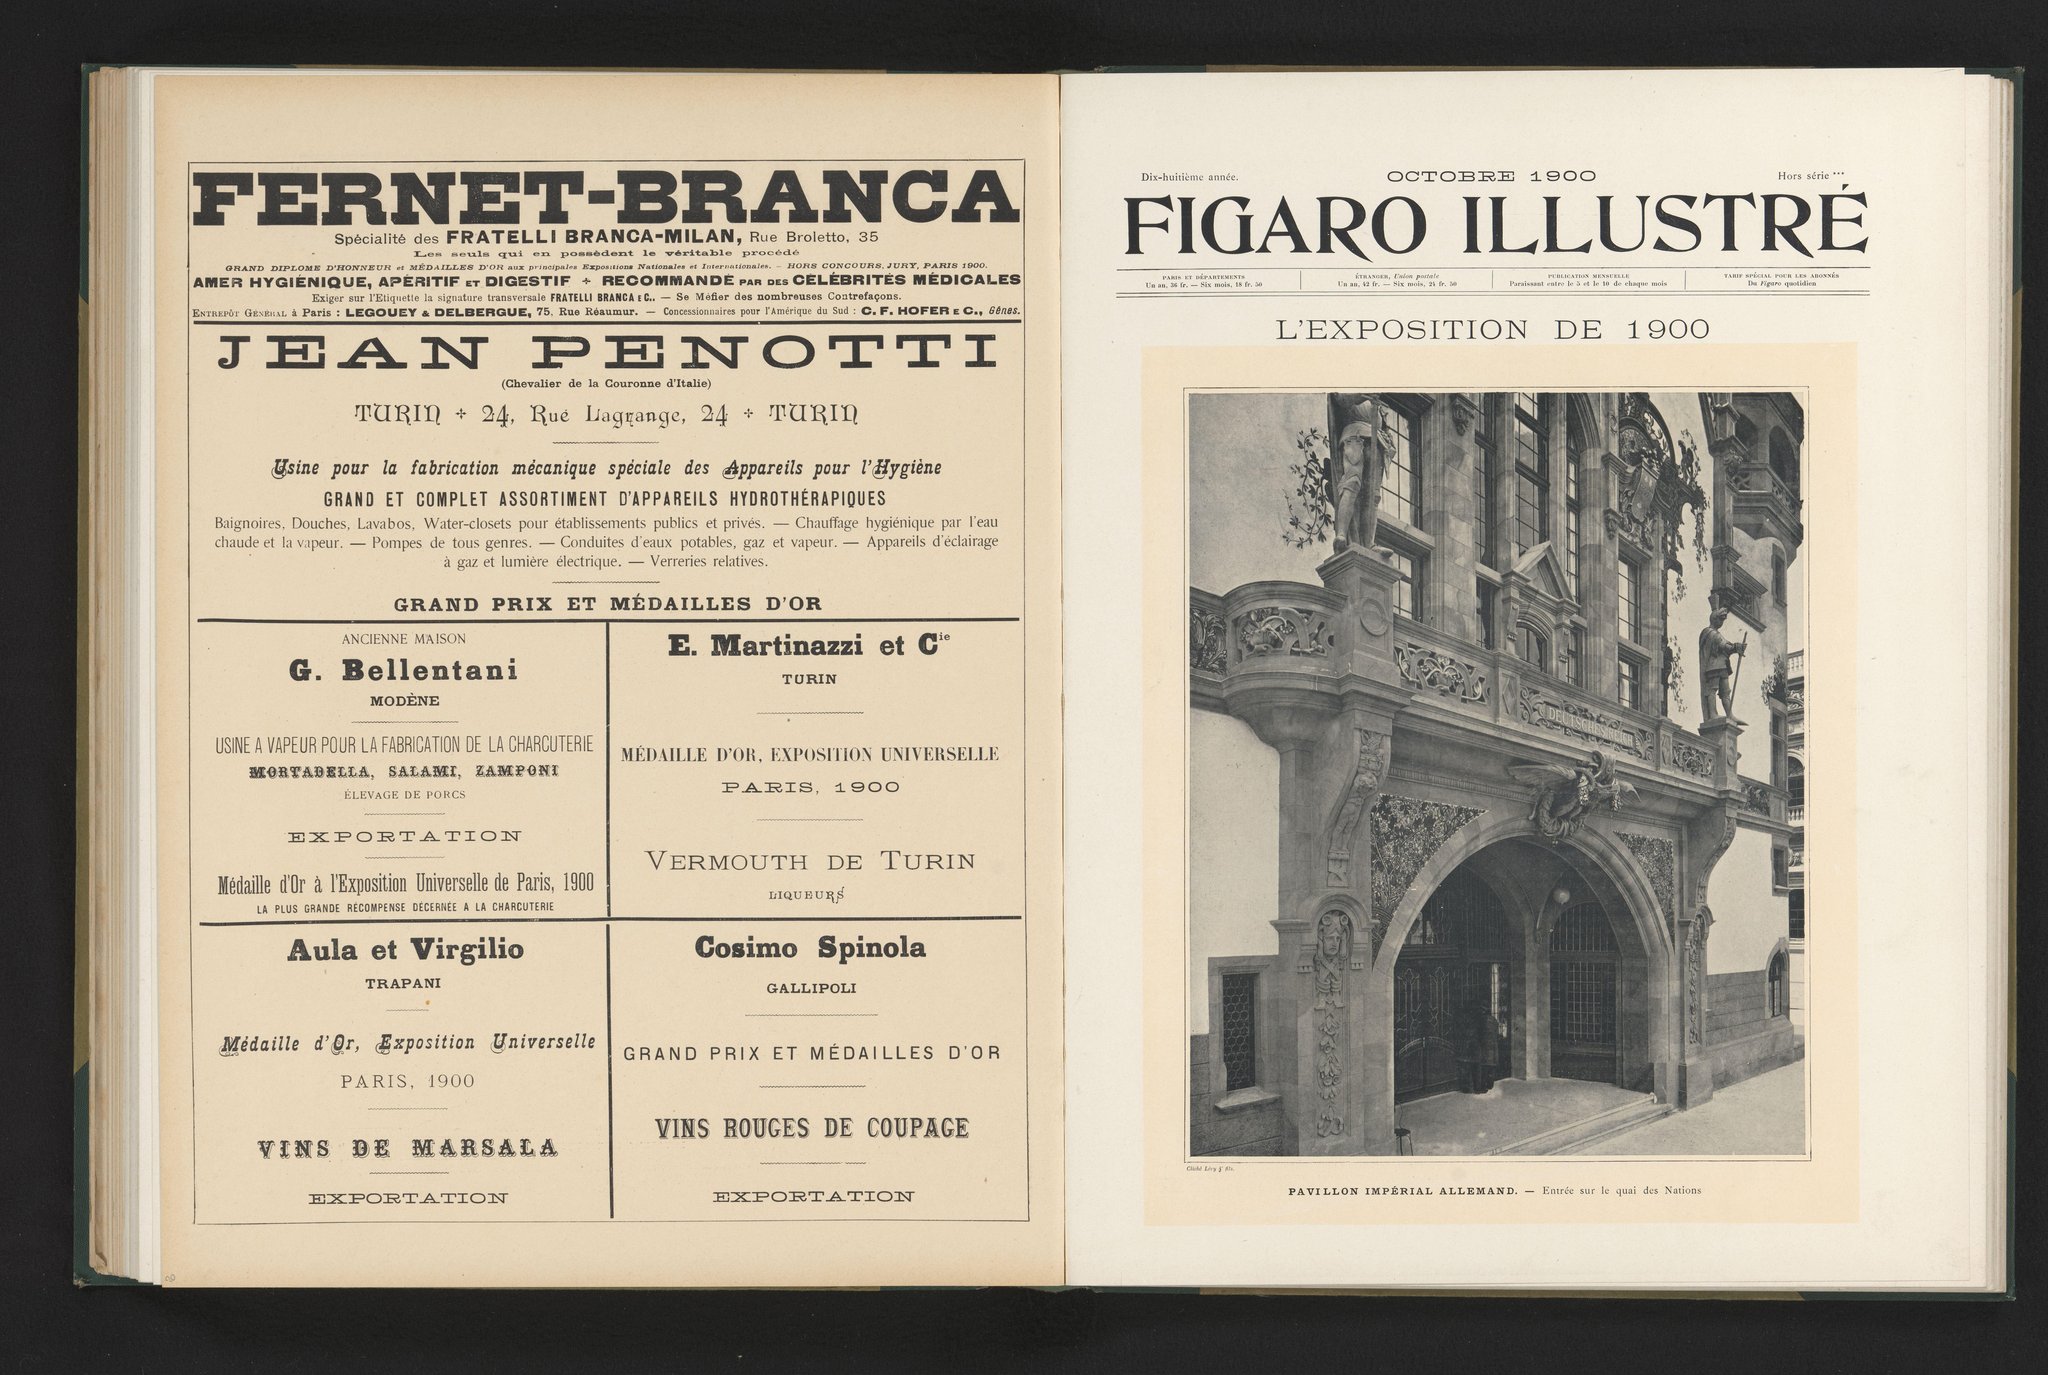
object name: photomechanical print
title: Pavillon impérial Allemand - Entrée sur le quai des Nations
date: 1885-1901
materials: paper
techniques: autotype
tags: world fair, world exhibition, gate, entrance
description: Prent op titelpagina van Figaro-Illustré (Octobre 1900).